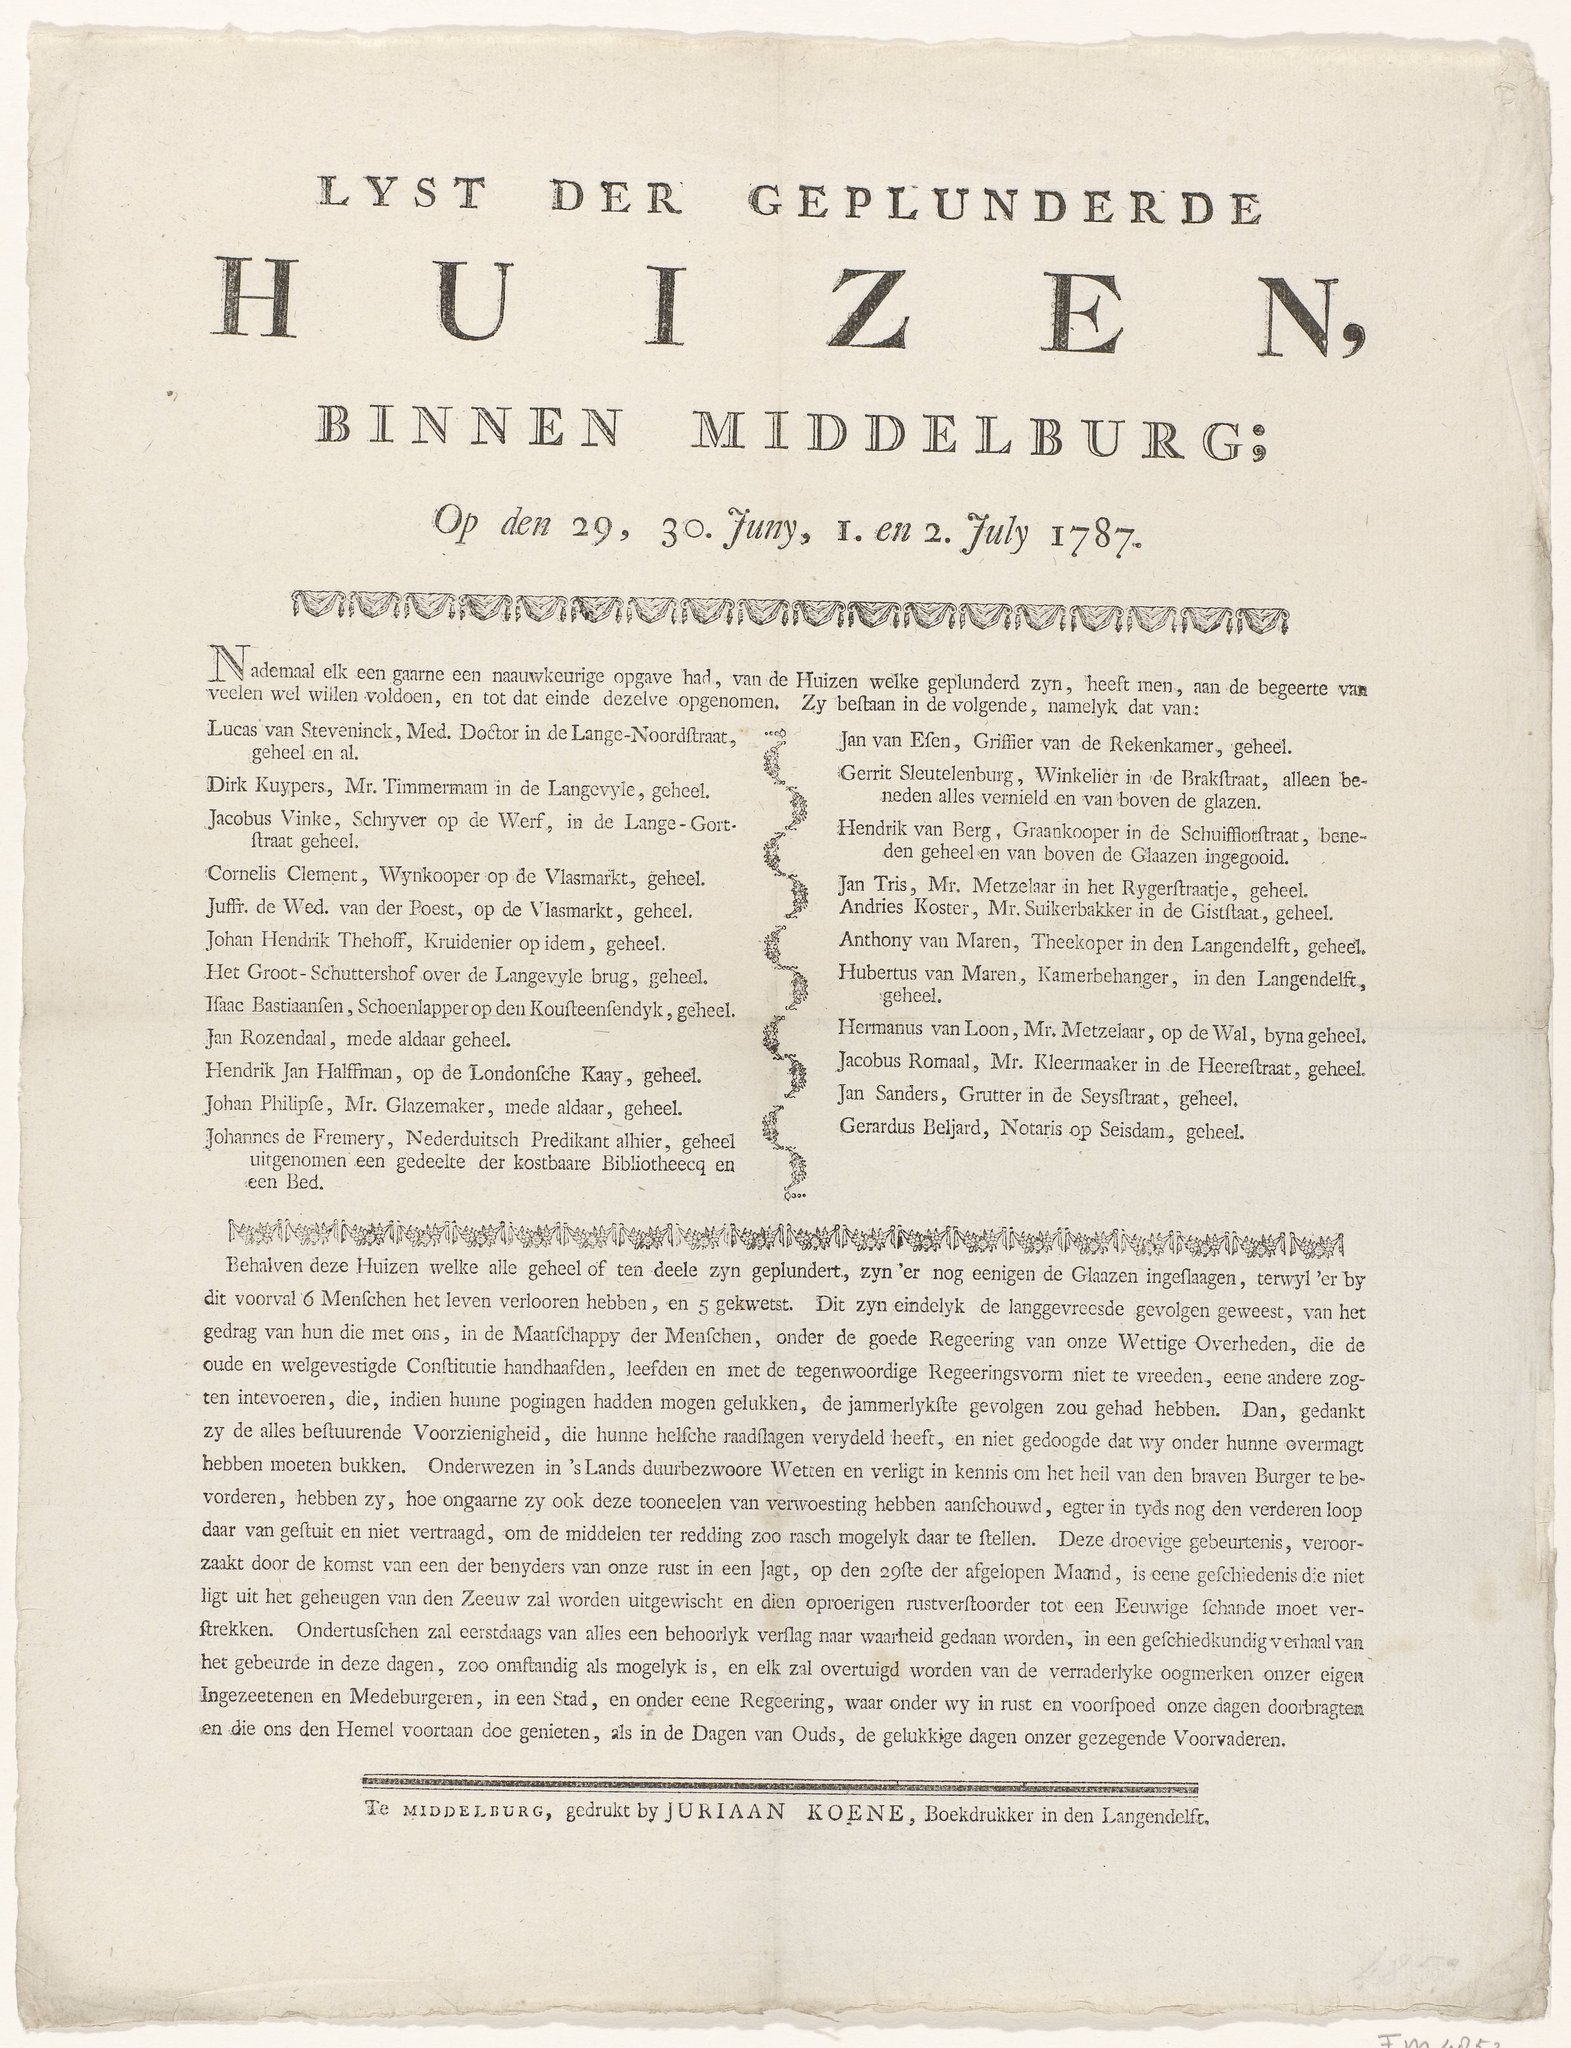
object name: text sheet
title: Lijst van de in 1787 geplunderde huizen te Middelburg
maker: juriaan koene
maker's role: printer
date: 1787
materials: paper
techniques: letterpress printing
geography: middelburg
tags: middelburg, patriots (1780-1795)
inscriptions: collector's mark: Lugt 2228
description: Tekstblad met een lijst van de huizen die geplunderd zijn tijdens de ongeregeldheden te Middelburg tussen 29 juni en 2 juli 1787. Bovenaan de lijst de naam van Lucas van Steveninck.